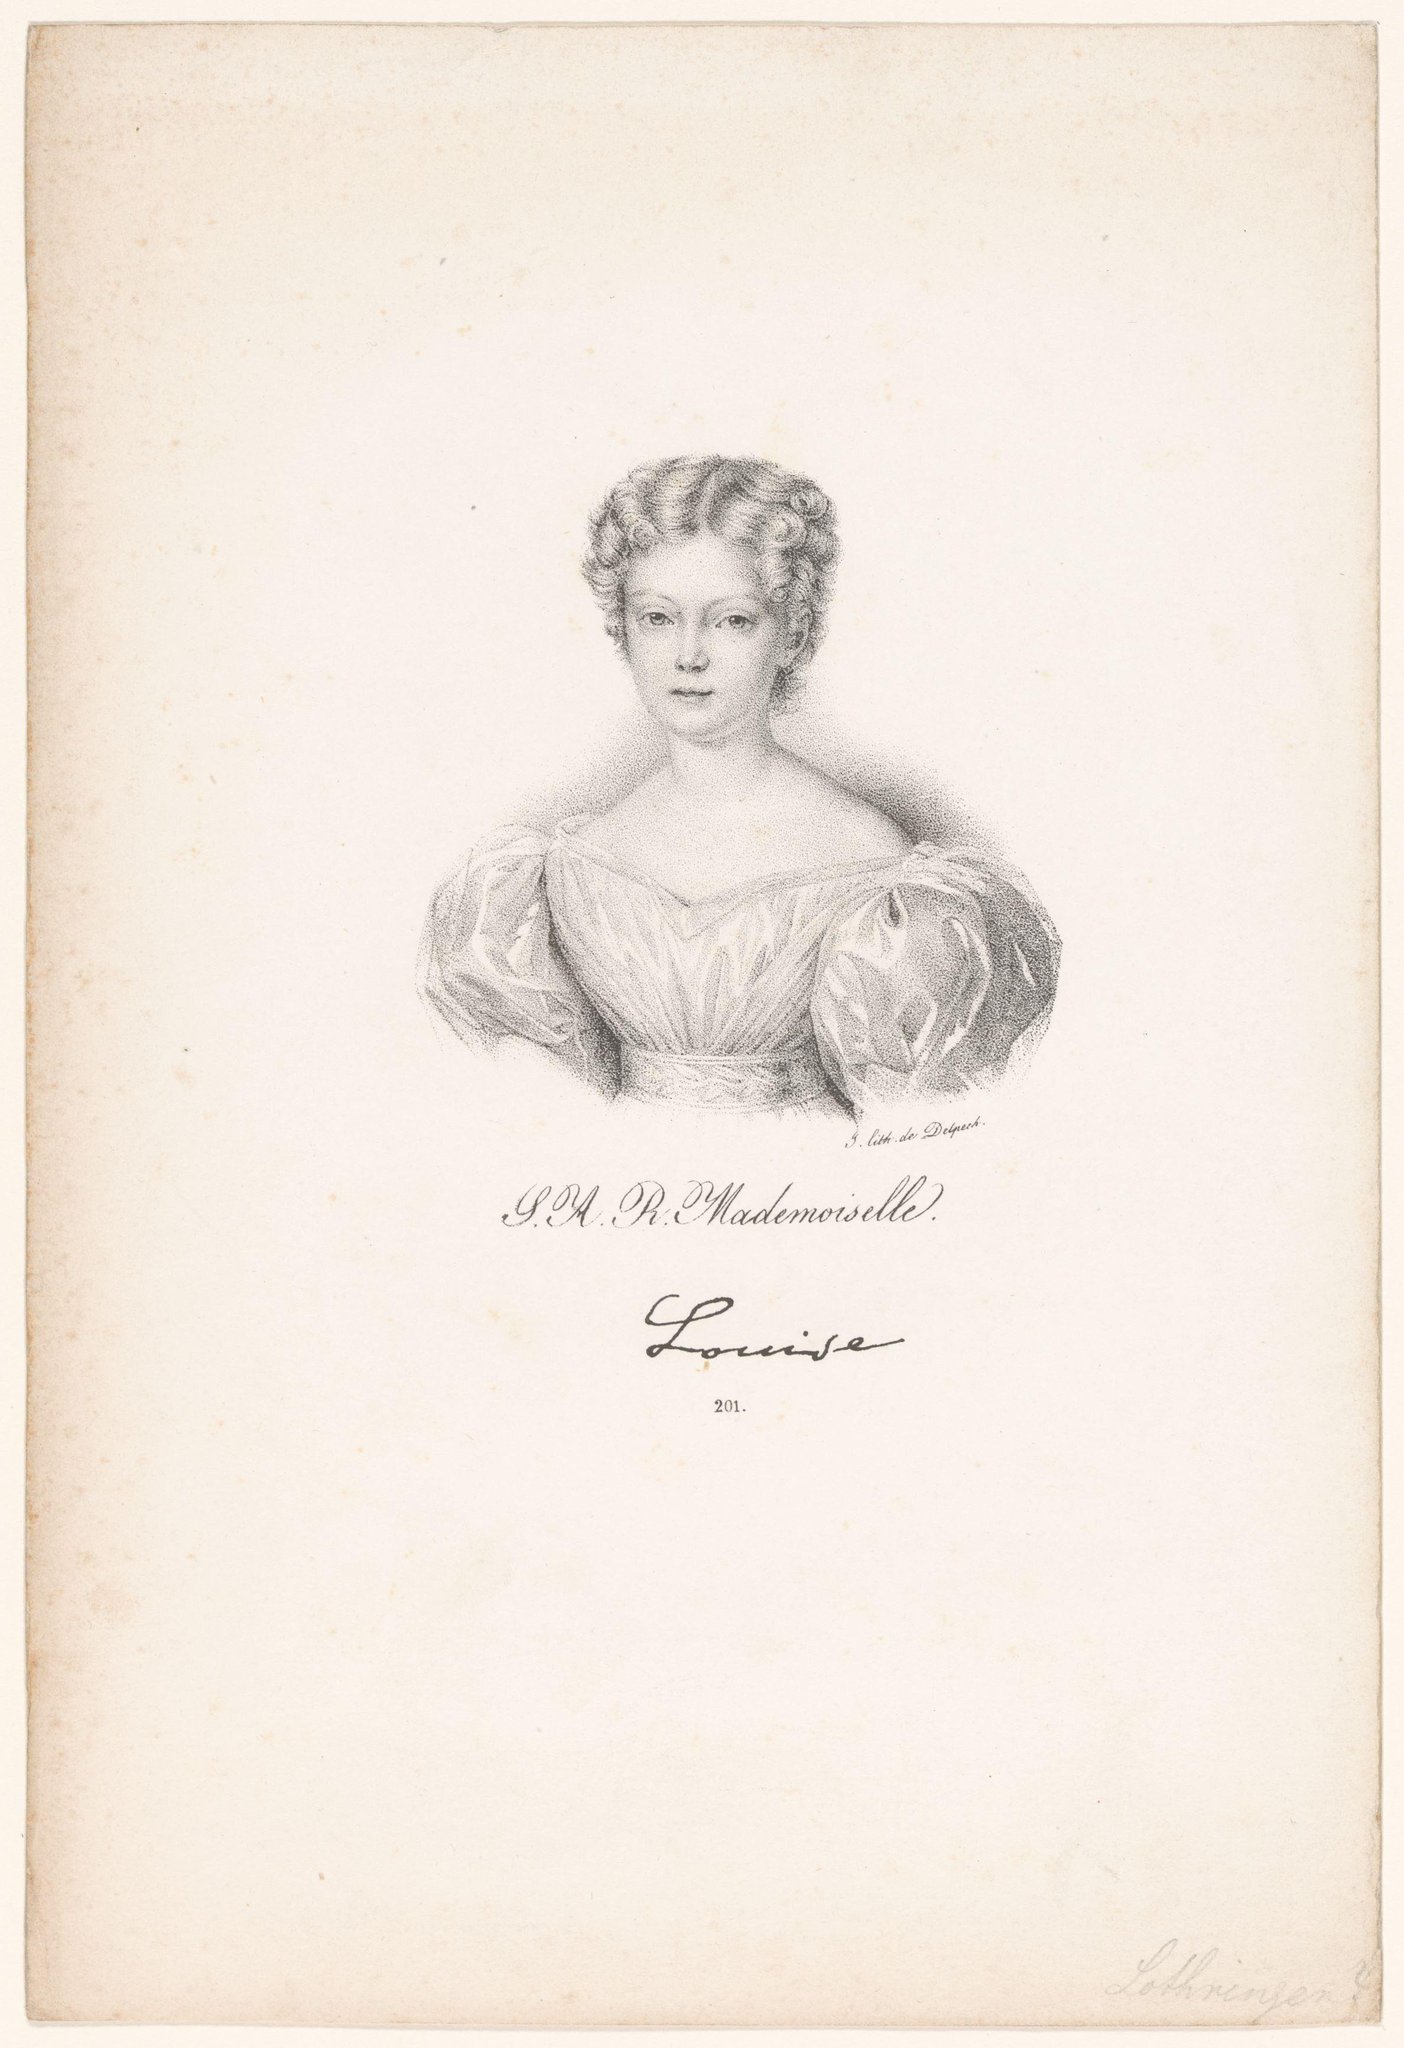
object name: print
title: S.A.R. Mademoiselle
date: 1830-1842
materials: paper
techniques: lithograph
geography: paris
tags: paris, venice, historical persons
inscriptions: collector's mark: Lugt 2228a